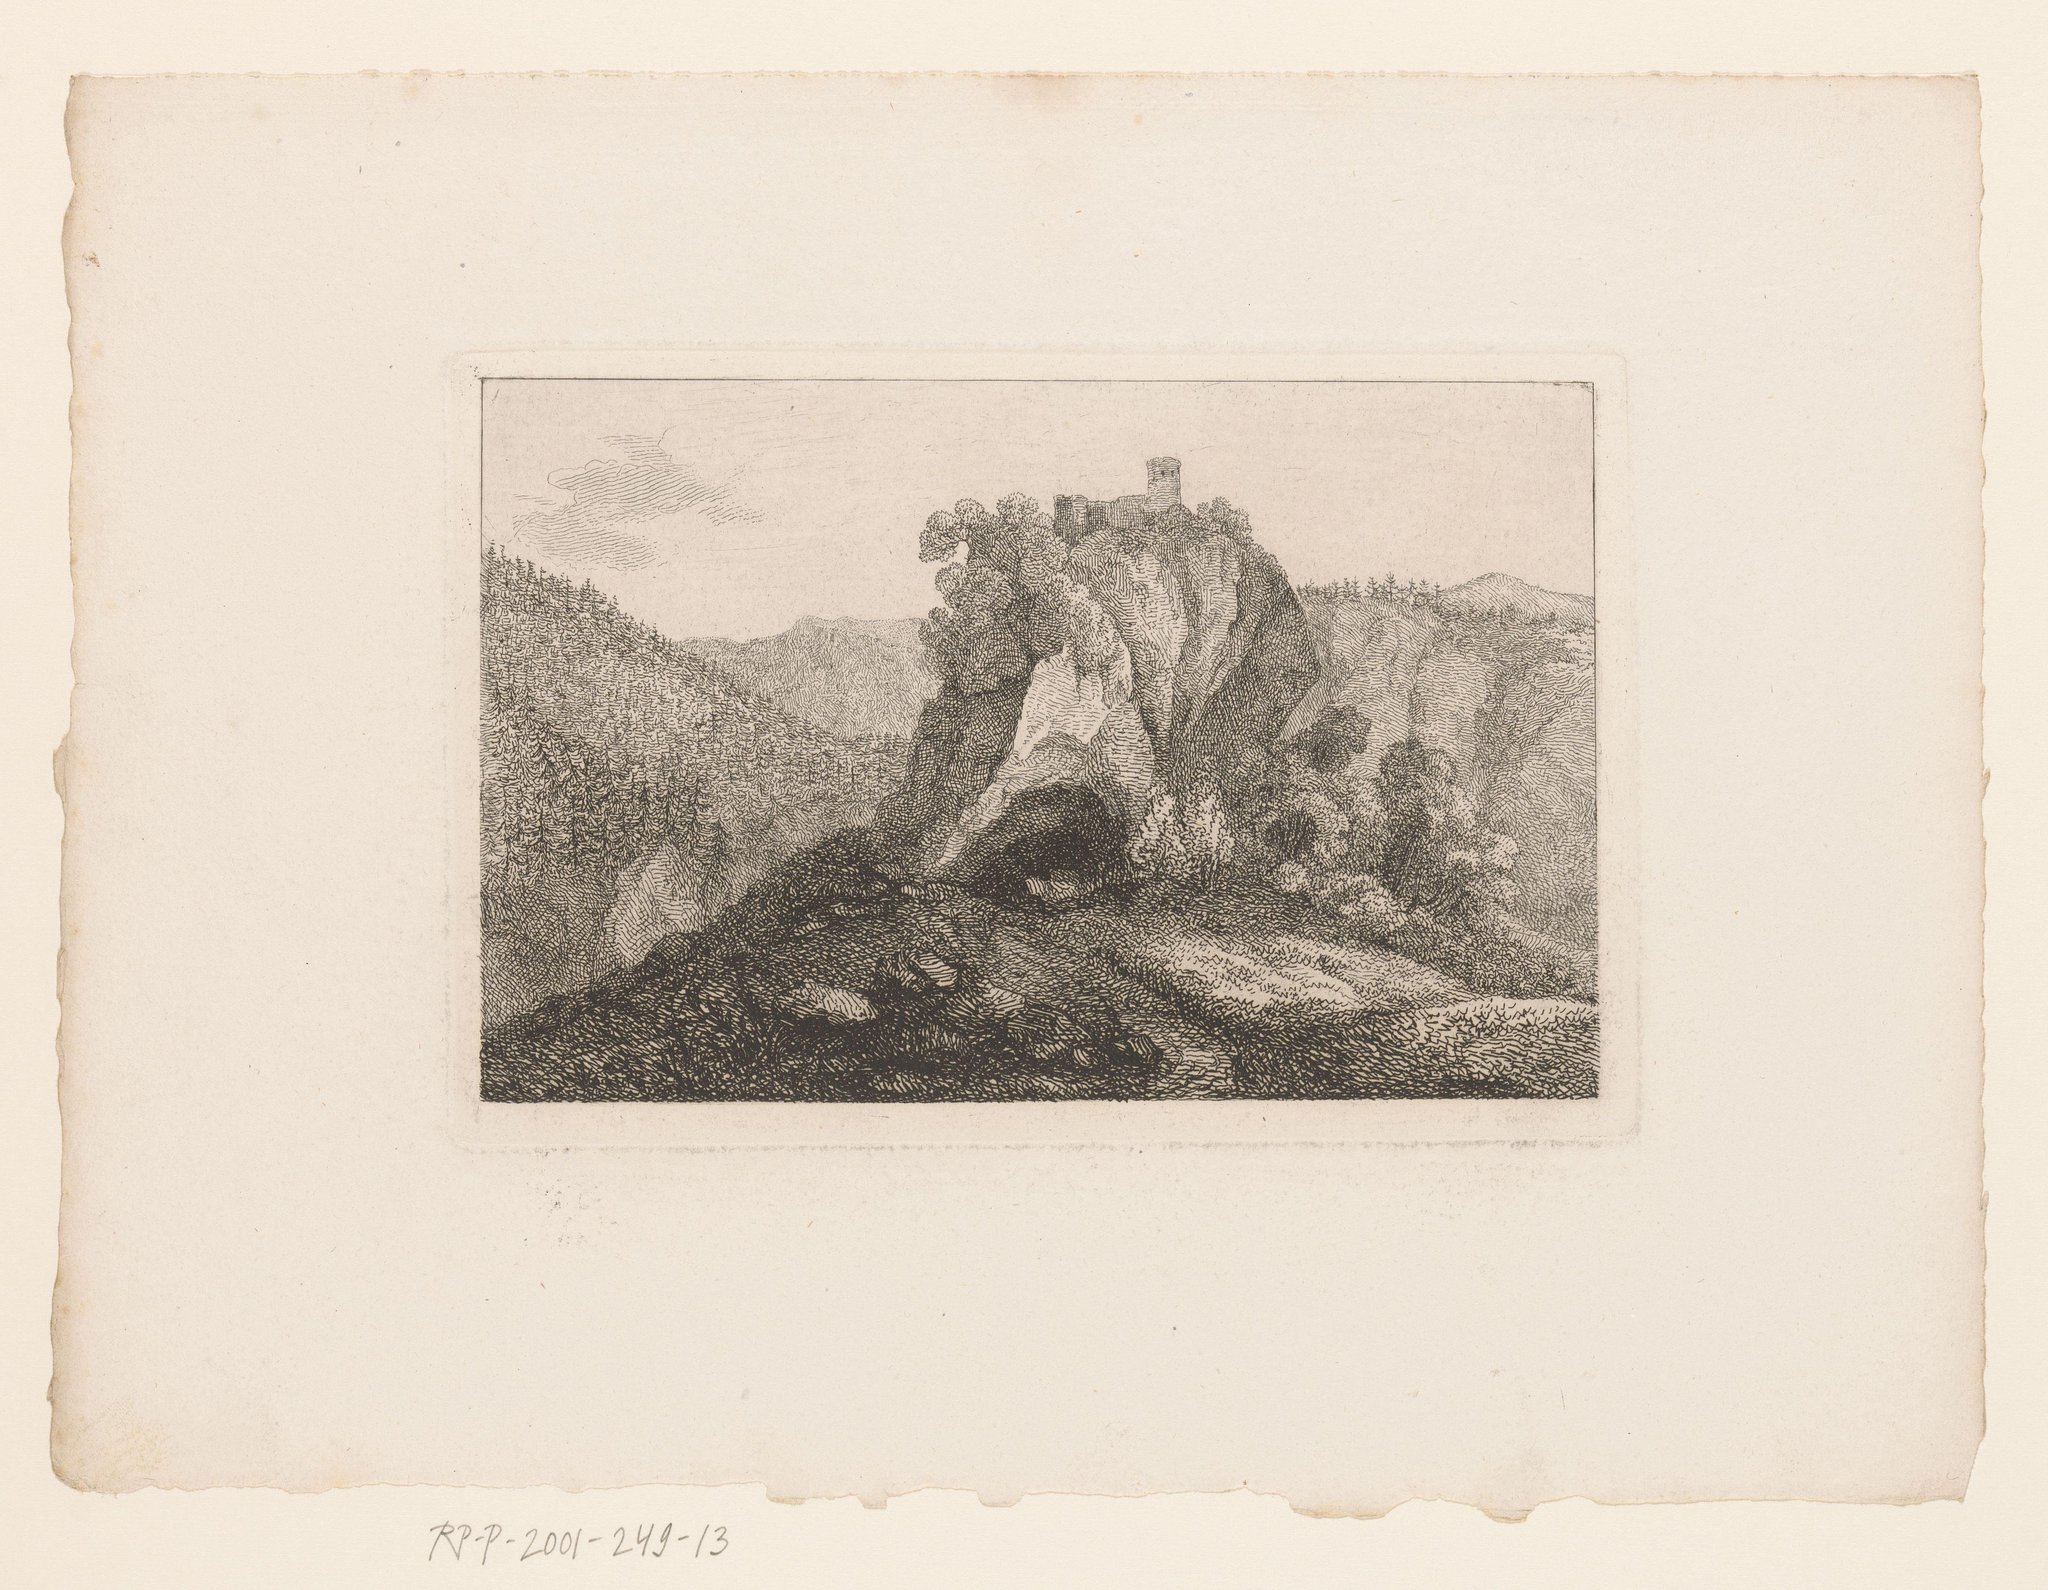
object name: print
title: Meine ersten Nadel Versuche: eine Folge von 28 Blättern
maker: marie anna fischer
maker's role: print maker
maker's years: 1782-1844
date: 1804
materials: paper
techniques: etching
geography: vienna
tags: landscape with ruins, cave, grotto, rock-formations, mountains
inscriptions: collector's mark: Lugt 2760, collector's mark: Lugt 2228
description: De originele prentserie bevat 40 prenten op 28 bladen. Het RMA heeft 33 prenten op 22 bladen in de collectie.